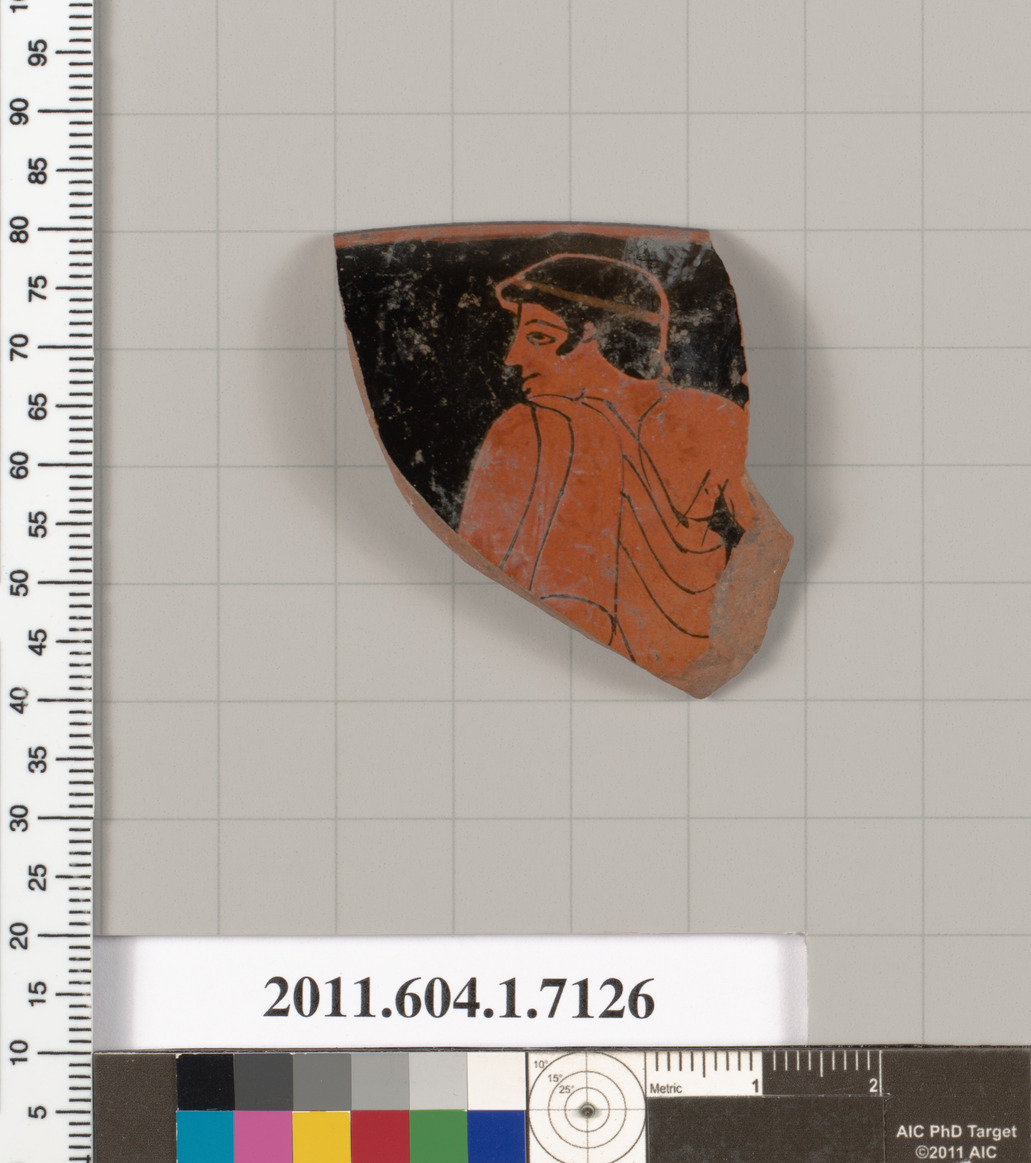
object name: kylix fragment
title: Terracotta rim fragment of a kylix (drinking cup)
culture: greek, attic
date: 475-451 BCE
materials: terracotta